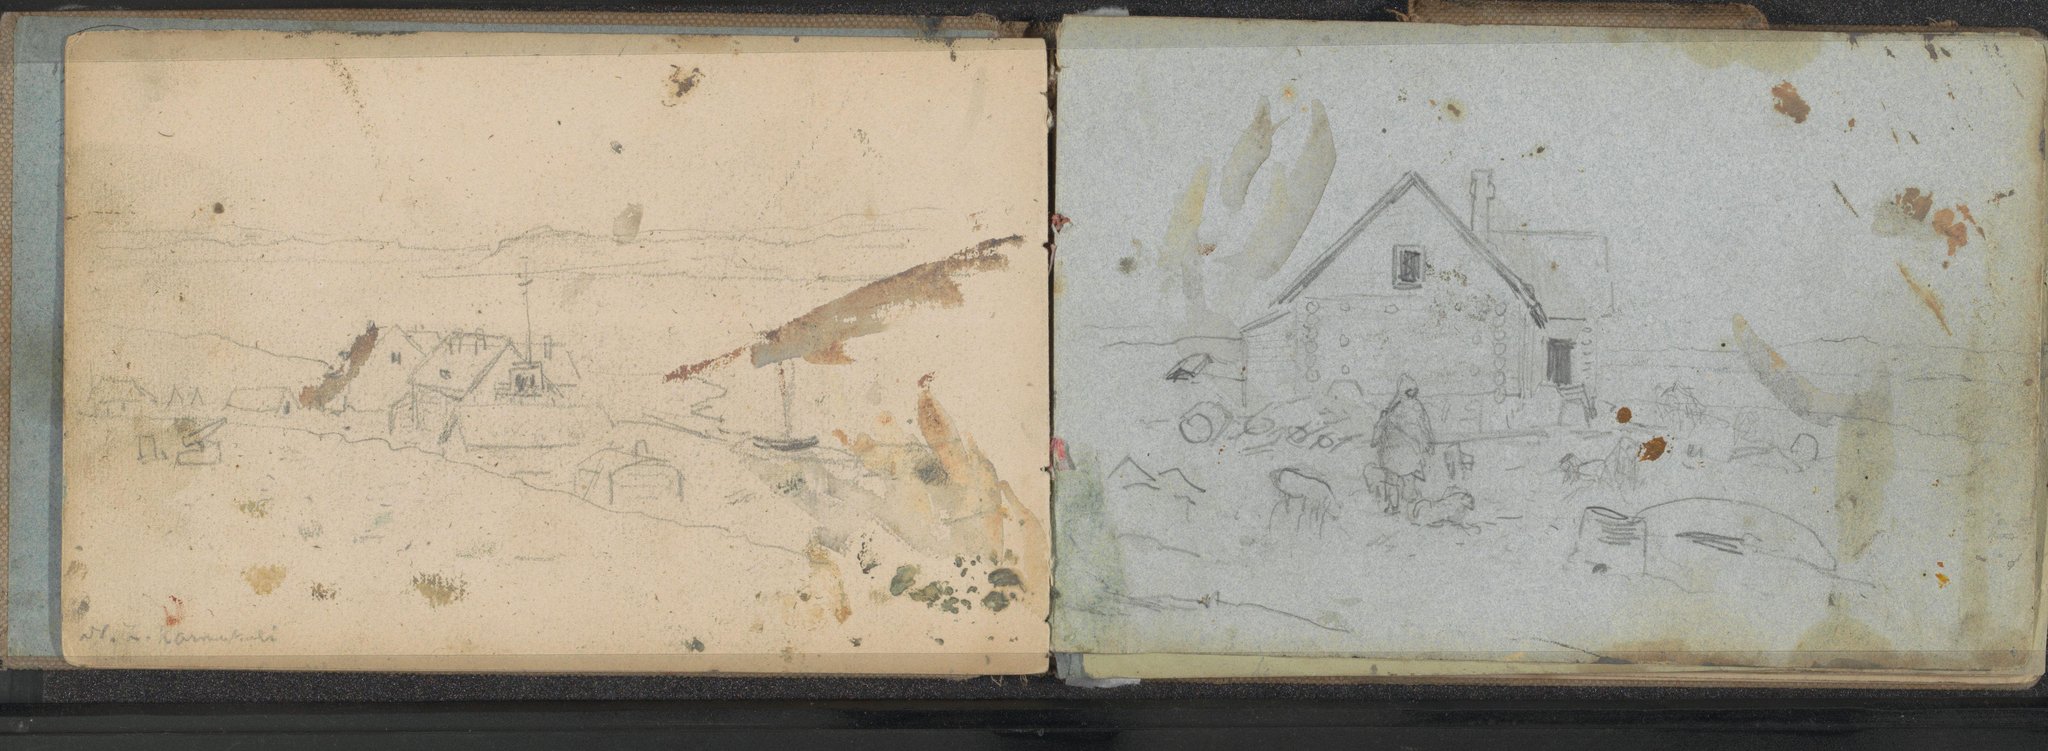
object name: sketchbook leaf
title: Gezicht op het Russische station te Malye Karmakuly, Nova Zembla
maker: louis apol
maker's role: draughtsman, painter, print maker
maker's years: 1850-1936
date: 1880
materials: paper, pencil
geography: malye karmakuly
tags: cattle, coast (in polar regions) (+ landscape (in the non-temperate zone) with figures, staffage), civic architecture; edifices; dwellings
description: Rond het huis dieren. Blad 5 recto uit een schetsboek met 35 bladen betekend tijdens de expeditie naar Nova Zembla in 1880.